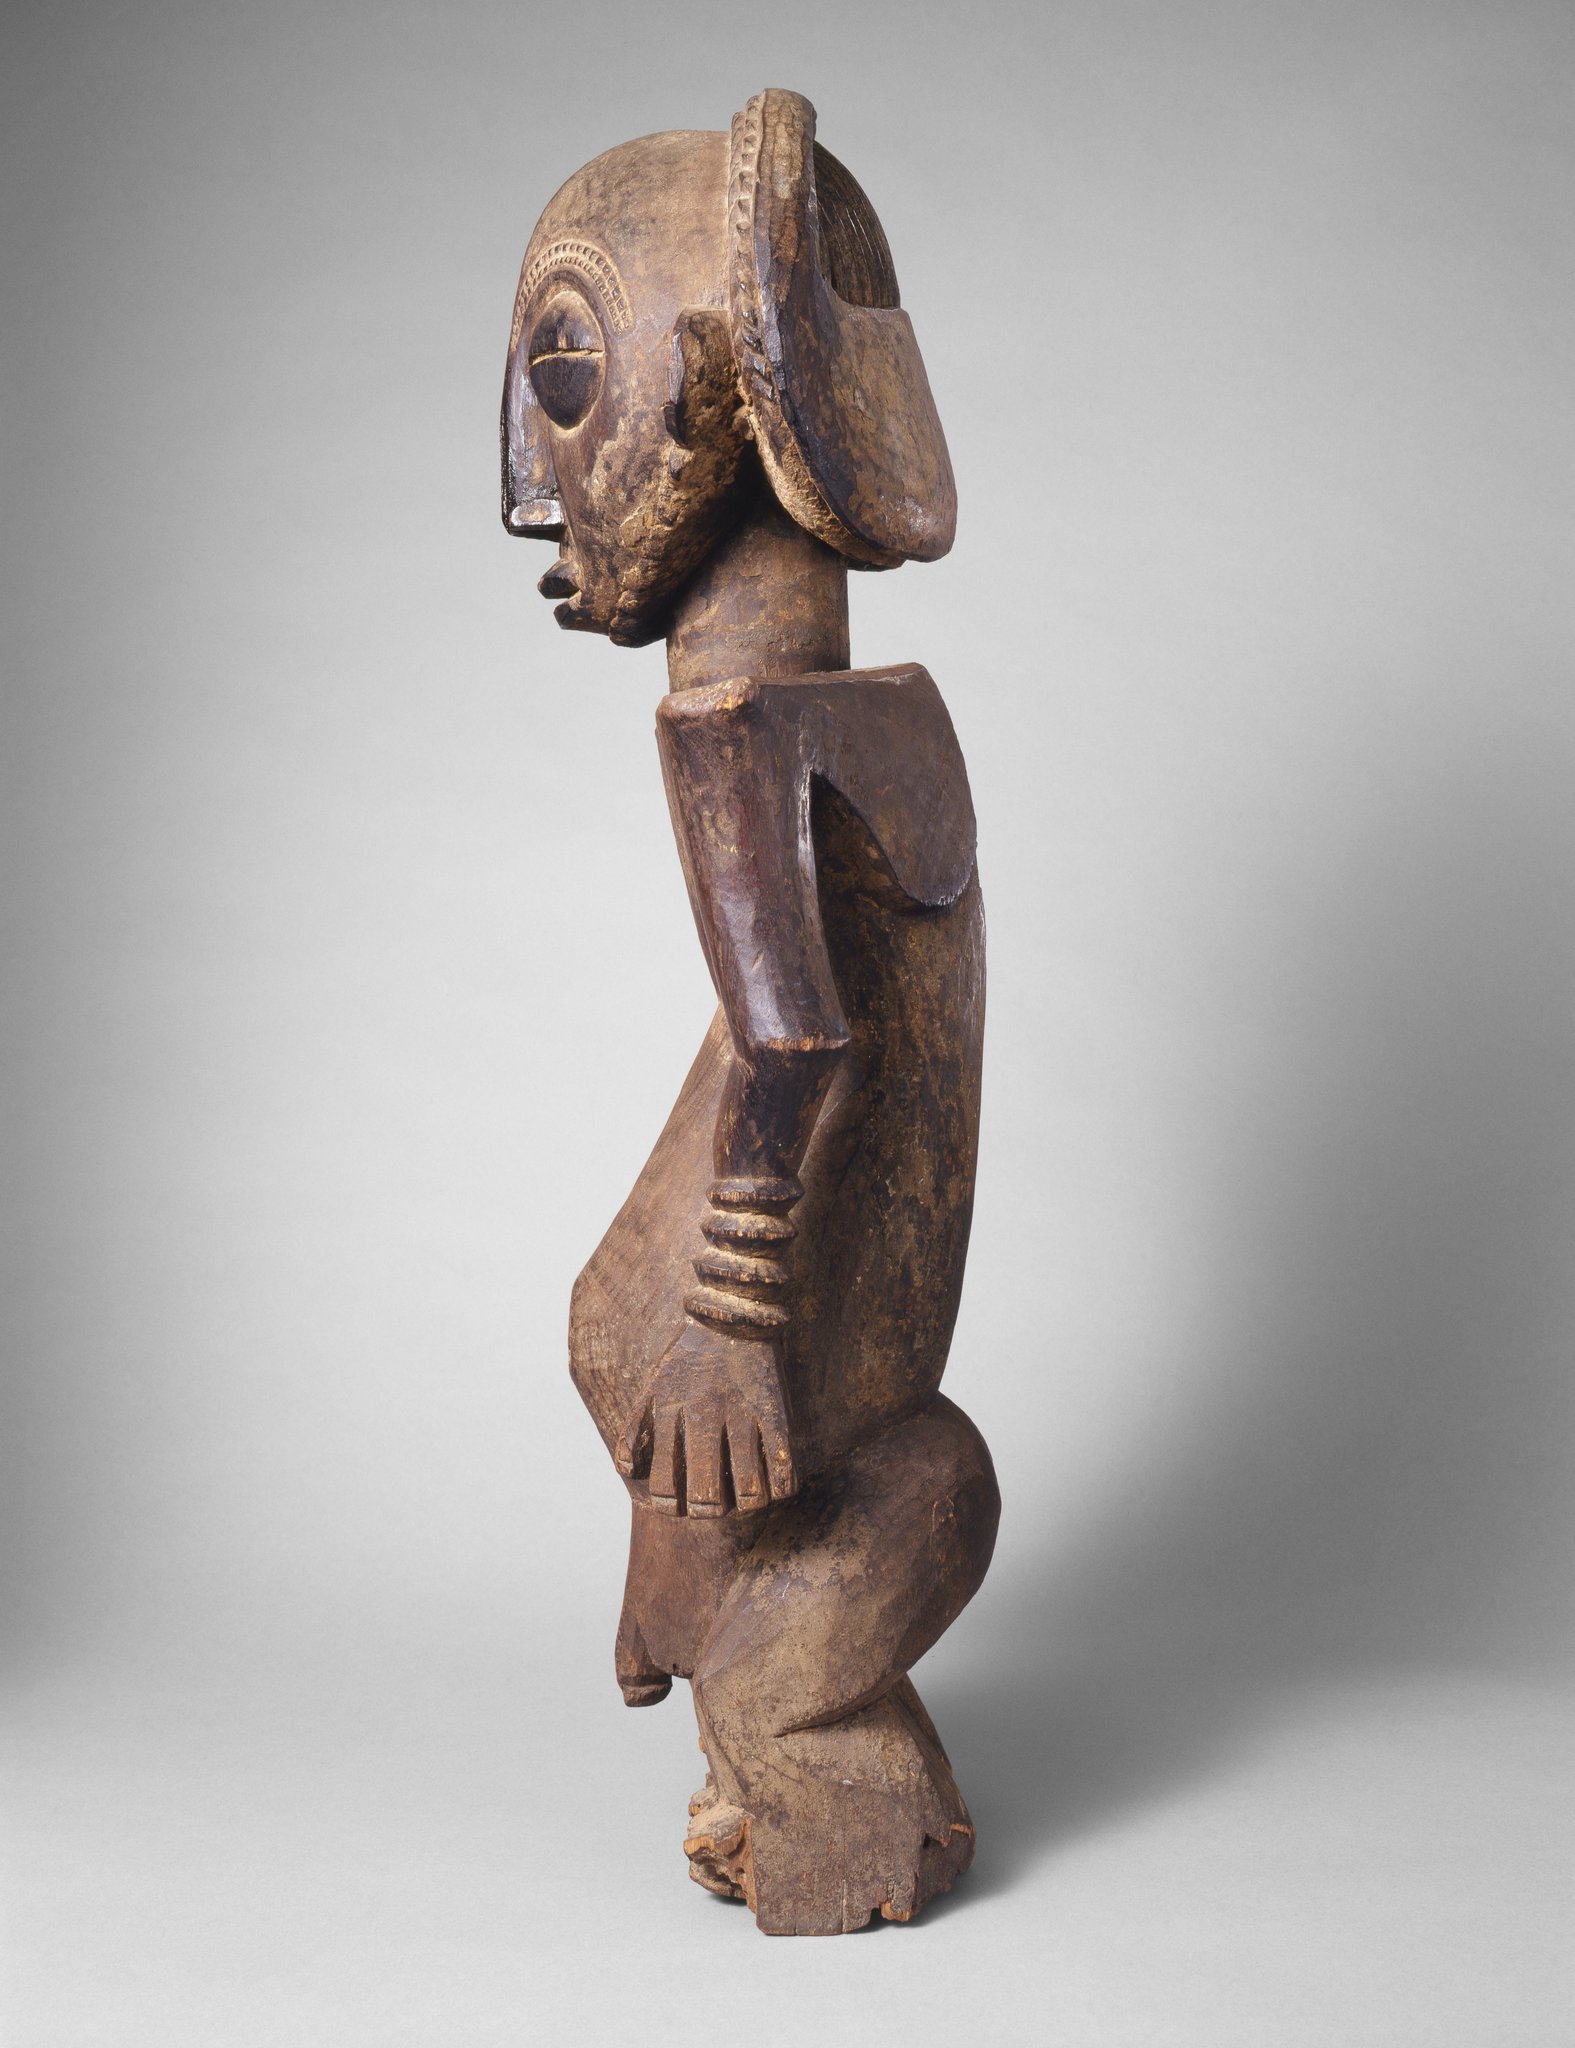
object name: male figure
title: Royal portrait of Akessa(?)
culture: boyo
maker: boyo artist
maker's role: artist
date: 1767-1900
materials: wood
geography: democratic republic of the congo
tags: men